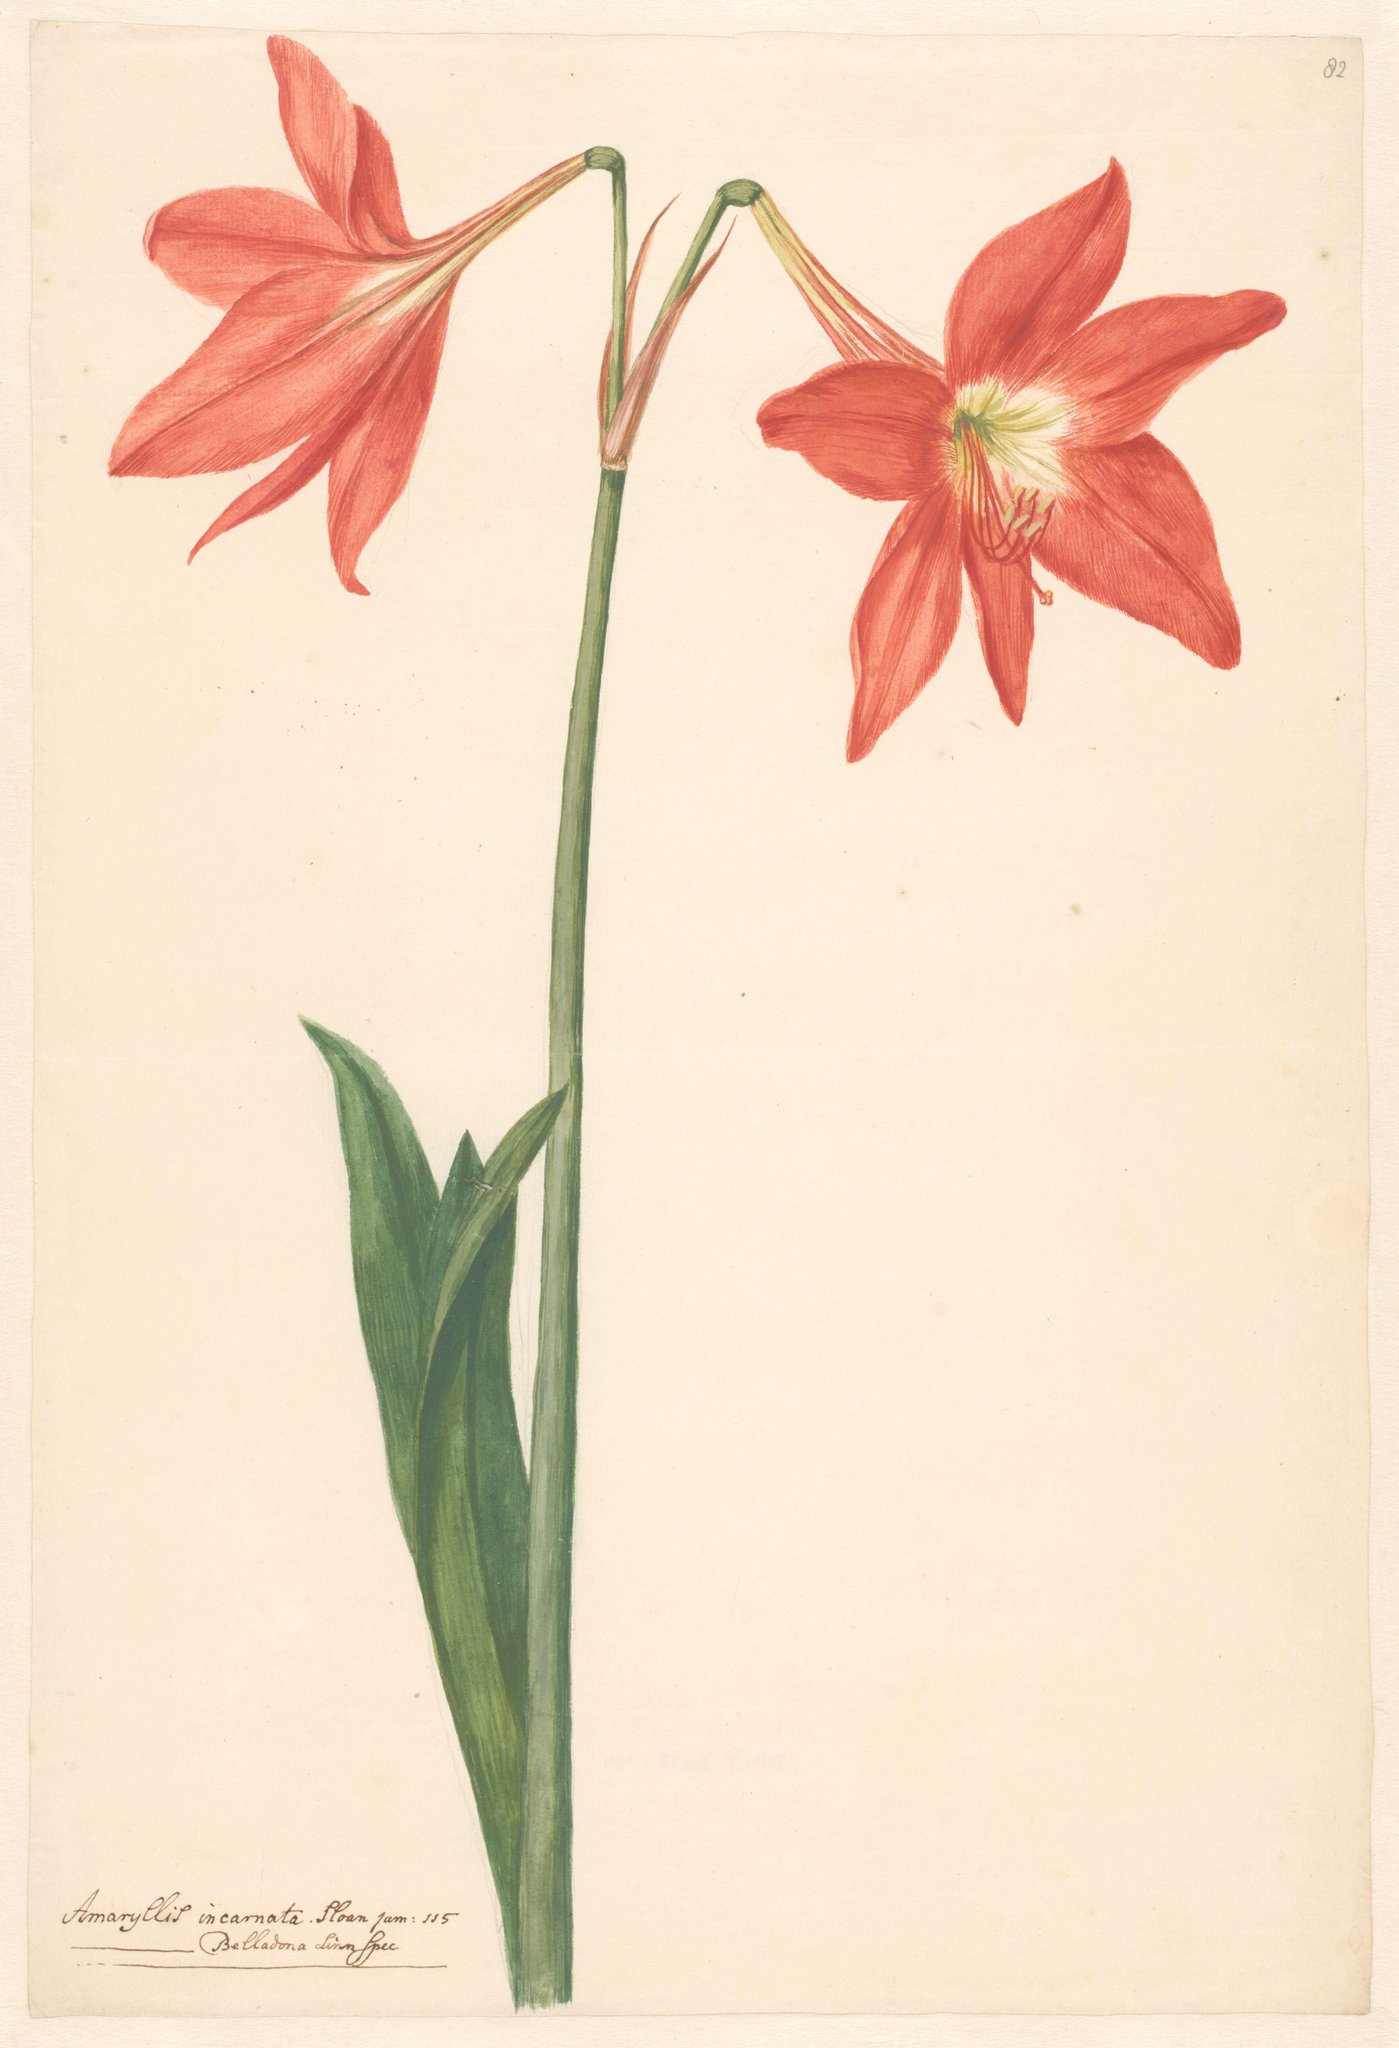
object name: drawing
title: Tak van rode amaryllis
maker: Anonymous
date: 1750-1799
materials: gouache, pencil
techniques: brush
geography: netherlands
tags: flowers: amaryllis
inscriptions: inscription: ‘82’, annotation: ‘Amaryllis incarnata. Sloan fam: 115 / [Amaryllis] Belladona Linn Spec’